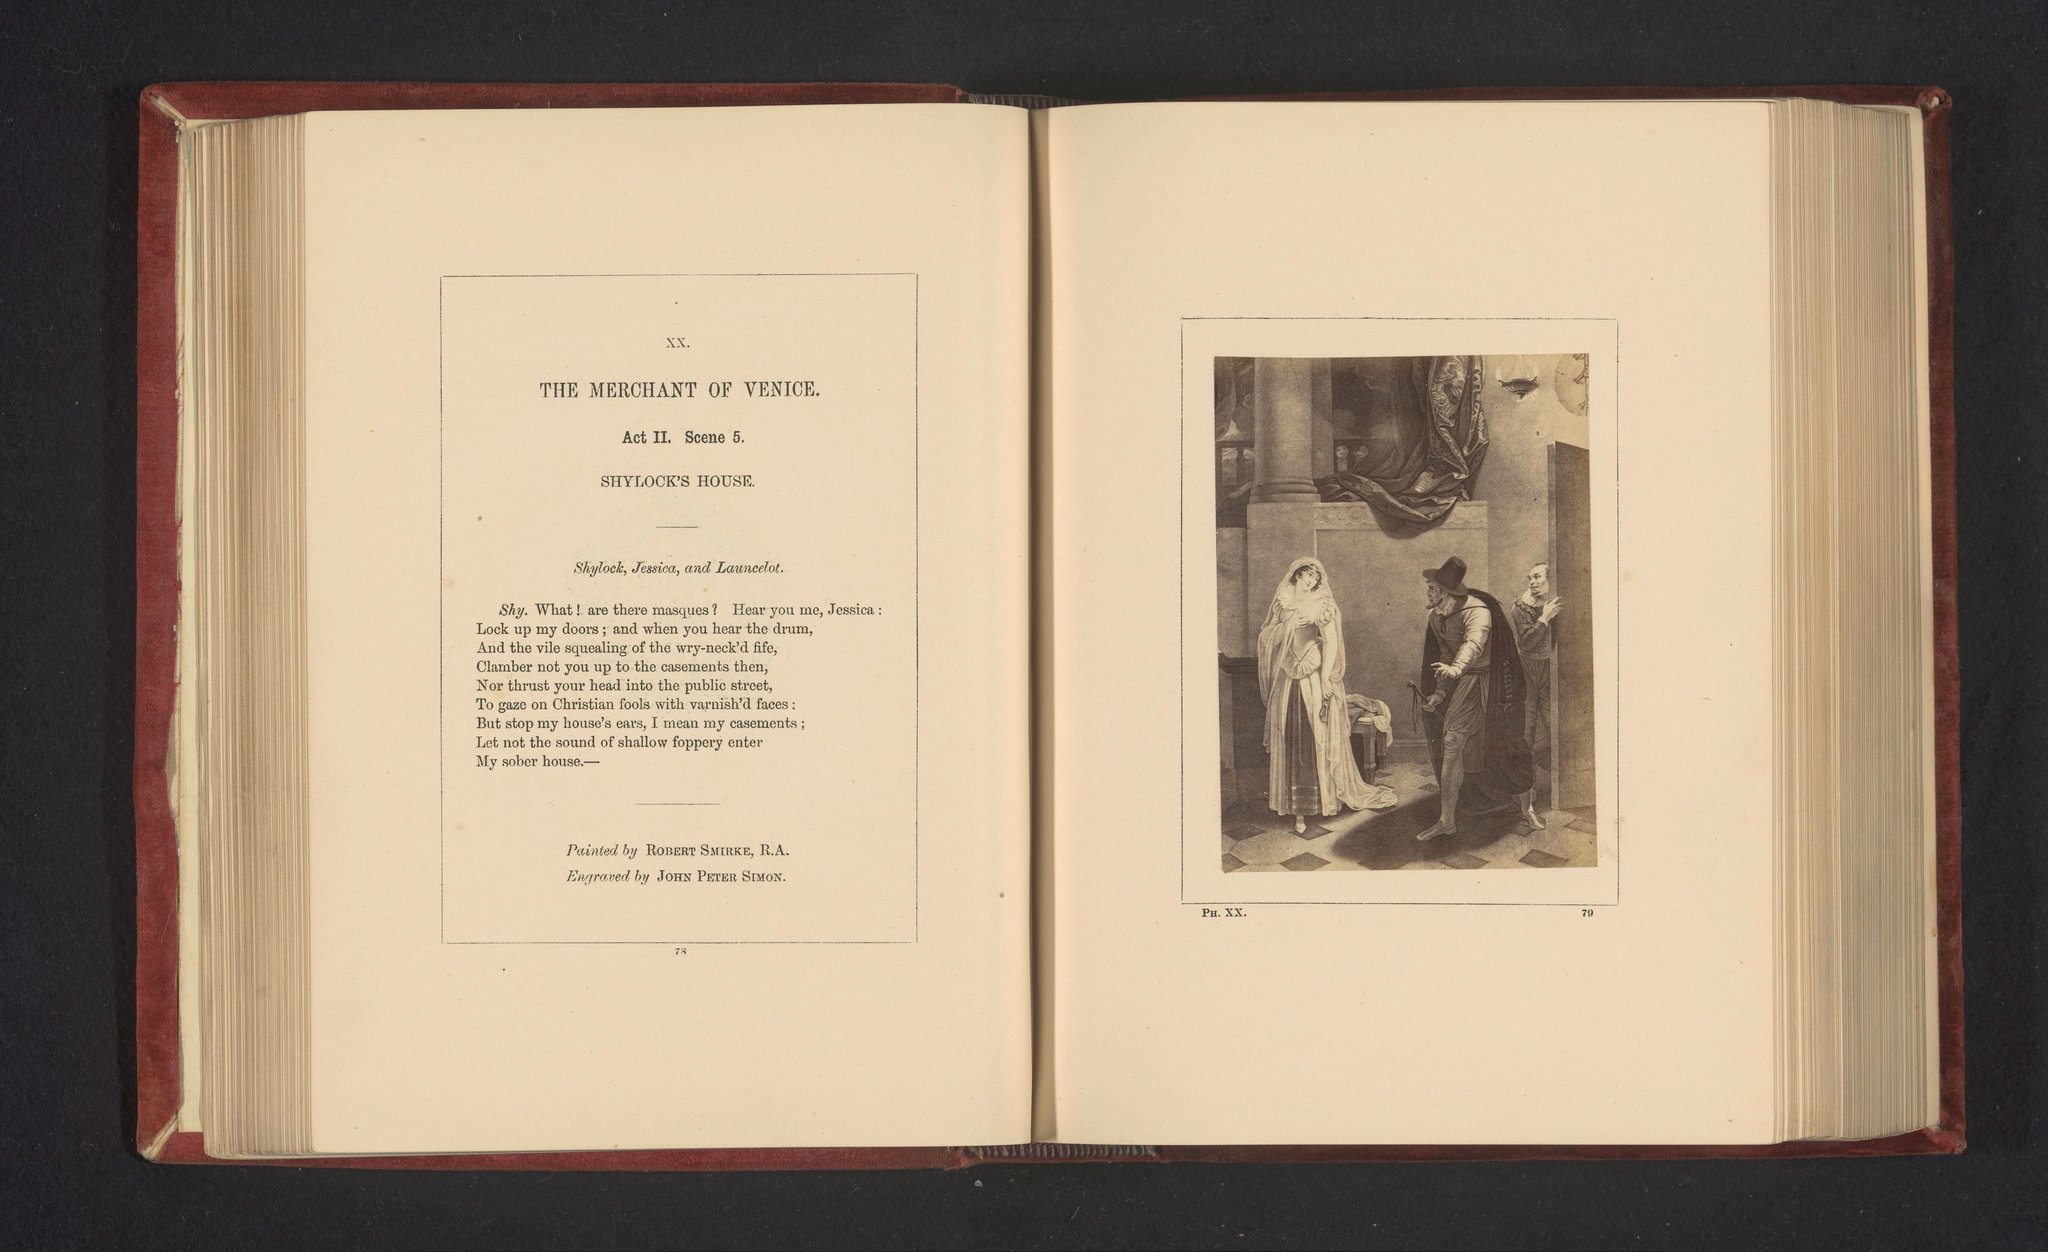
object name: photograph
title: Fotoreproductie van een prent naar een schilderij door Robert Smirke, voorstellend een scene uit De koopman van Venetië door William Shakespeare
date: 1854-1864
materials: photographic support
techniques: albumen print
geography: london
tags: specific works of literature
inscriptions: number: ‘Ph. XX. 79’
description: Te zien is akte II, scene 5 met Shylock, Jessica en Lancelot Gobbo in het huis van Shylock.